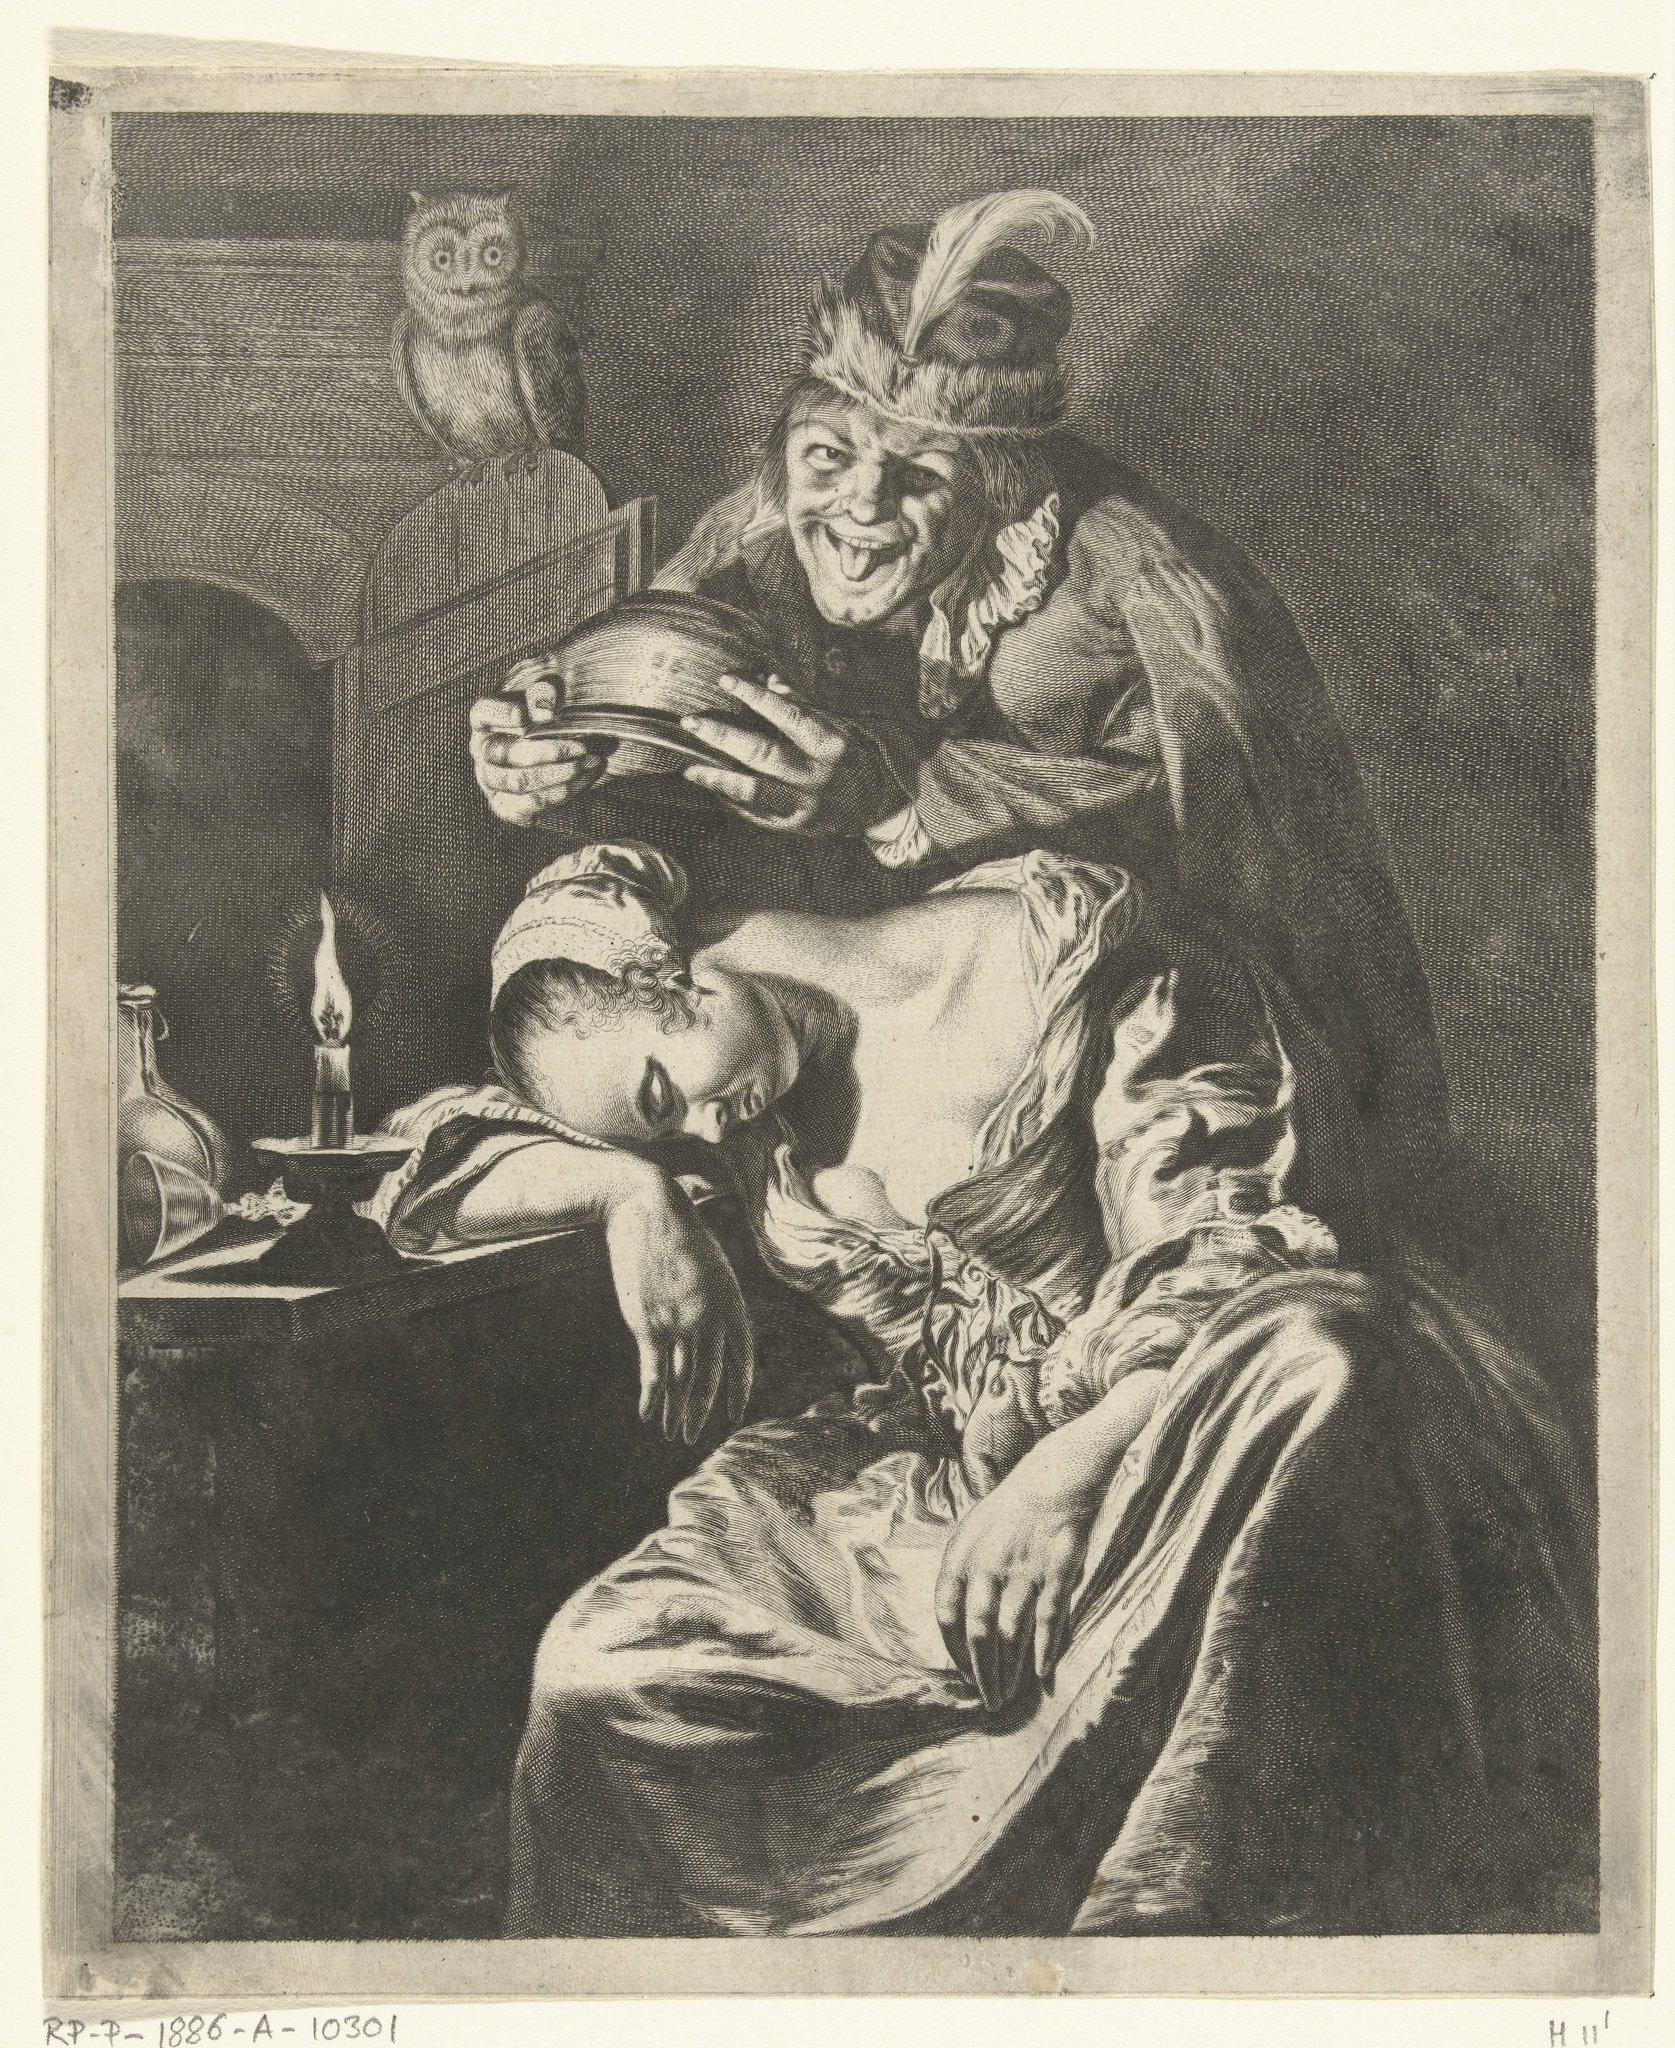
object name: print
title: De wijn is een spotter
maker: hendrik bary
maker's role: draughtsman, print maker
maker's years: 1640-1707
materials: paper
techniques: engraving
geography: netherlands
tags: candle, drunkenness, chamber-pot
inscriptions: collector's mark: Lugt 2228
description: Een nar-achtige figuur staat op het punt om een slapende vrouw een pispot op het hoofd te zetten.